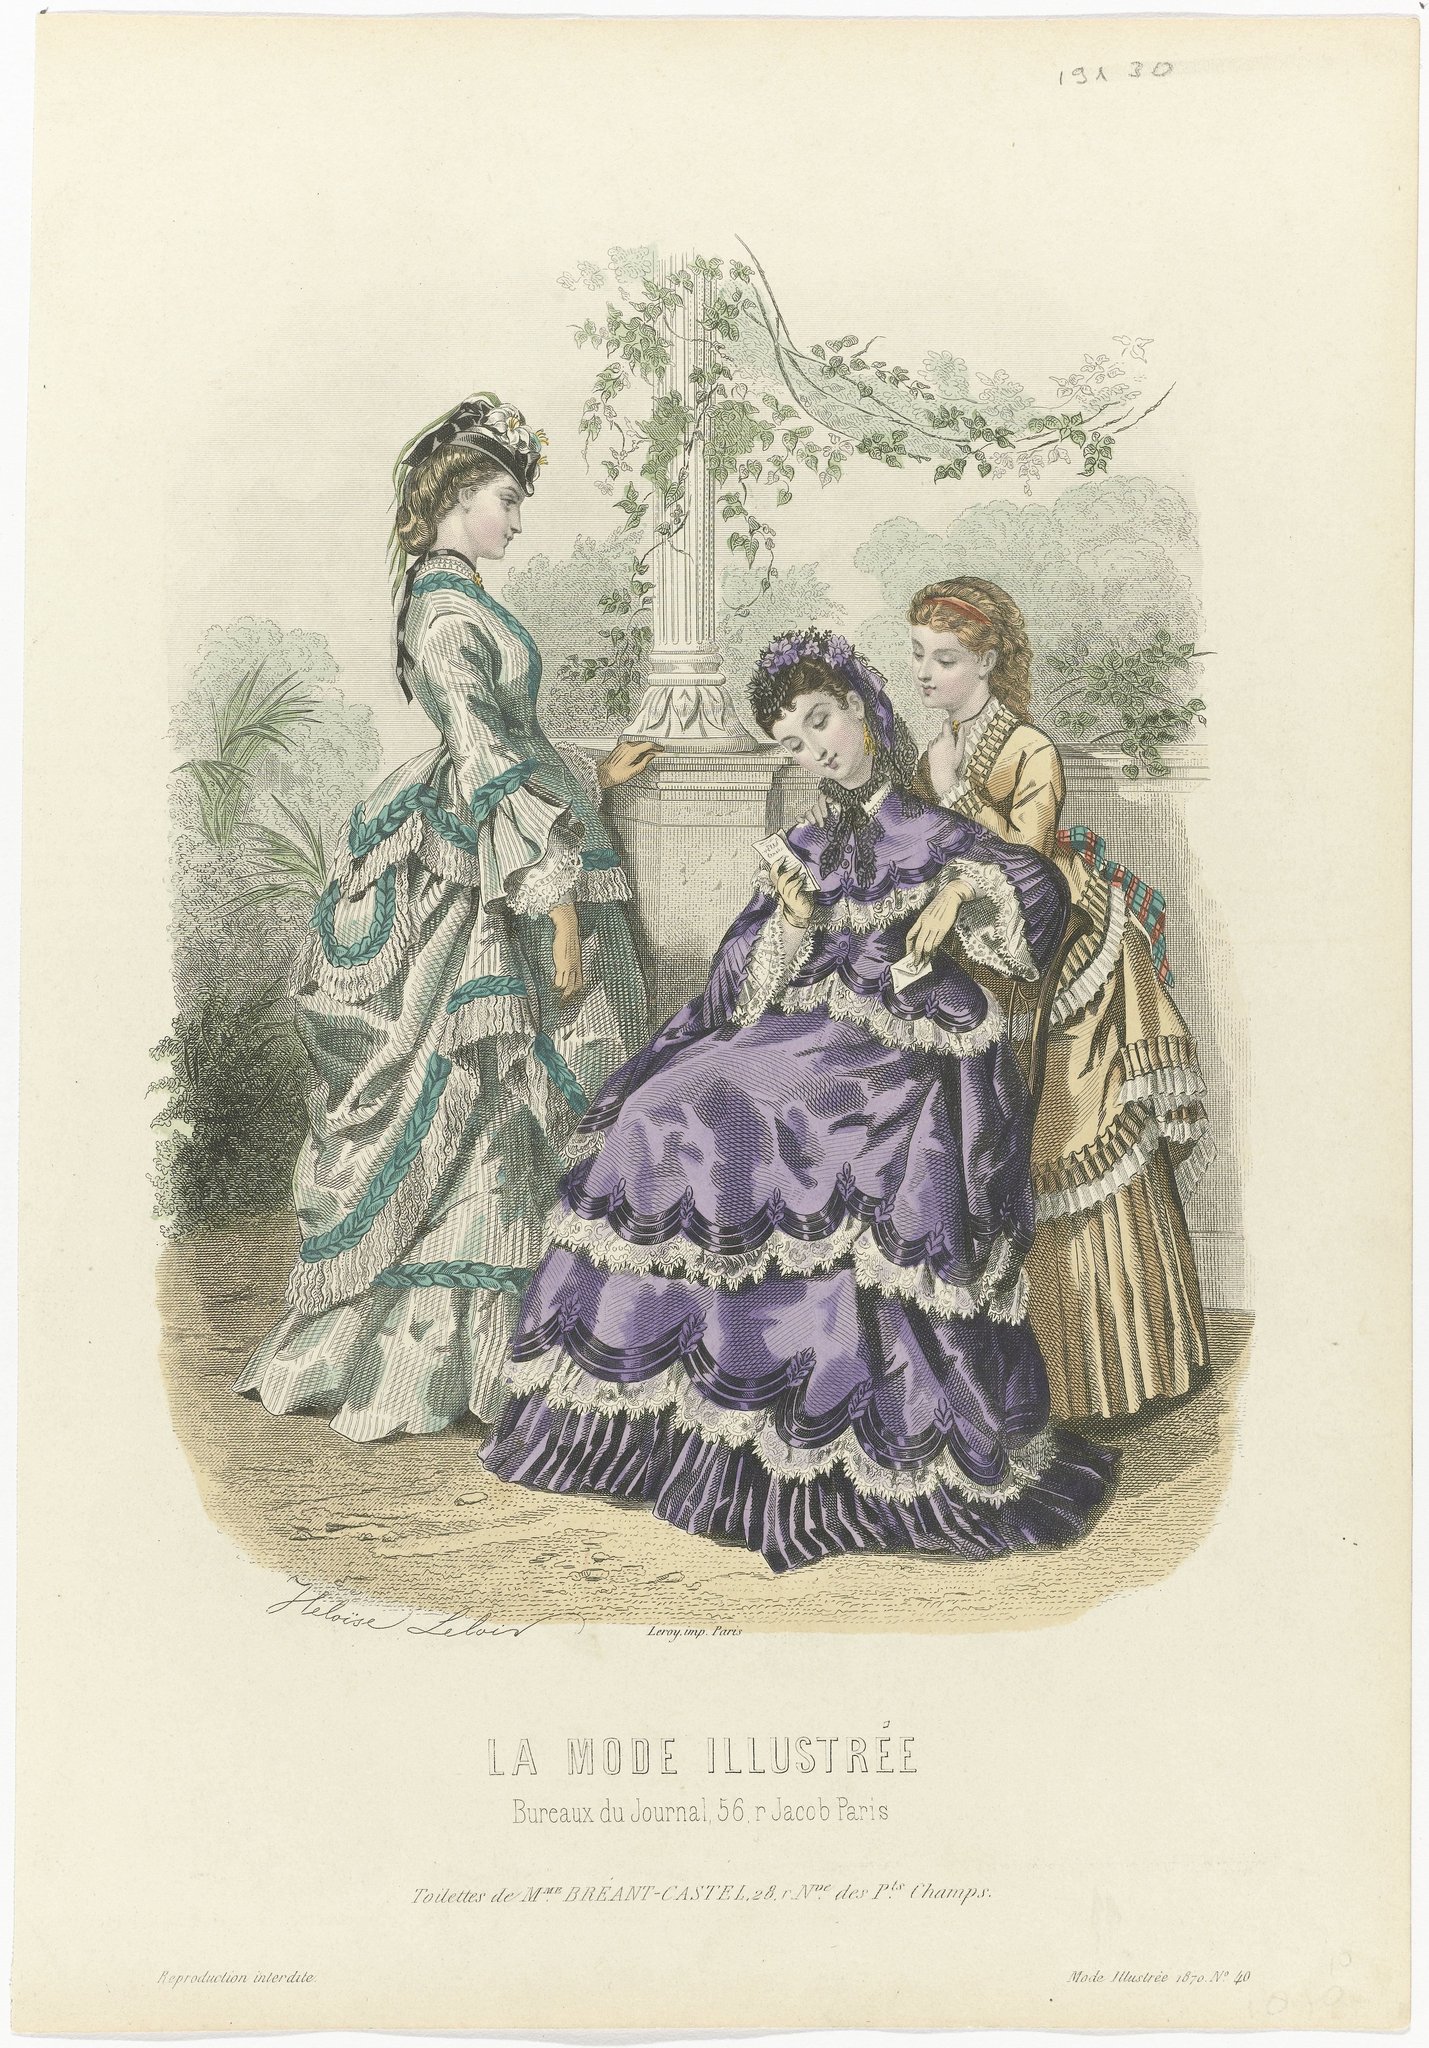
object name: fashion print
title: La Mode Illustrée, 1870, No. 40: Toilettes de Mme Breant-Castel (...)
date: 1870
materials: paper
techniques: engraving, hand coloring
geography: paris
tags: ear-rings (+ women's clothes), pendant, trinket, 'breloque' (+ women's clothes), pendant, trinket, 'breloque' (+ girls' clothes), head-gear (+ women's clothes), fashion plates, gloves, mittens, etc. (+ women's clothes), letter, envelope, dress, gown (+ girls' clothes)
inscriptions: caption: ‘Toilettes de Mme Bréant-Castel, 28.r. Nve des Pts Champs.’, address: ‘Bureaux du Journal, 56, Rue Jacob. Paris’, title: ‘La Mode Illustrée’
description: Twee vrouwen en een meisje zijn buiten, gekleed in japonnen van Bréant-Castel. Prent uit het modetijdschrift La Mode Illustrée (1860-1937).